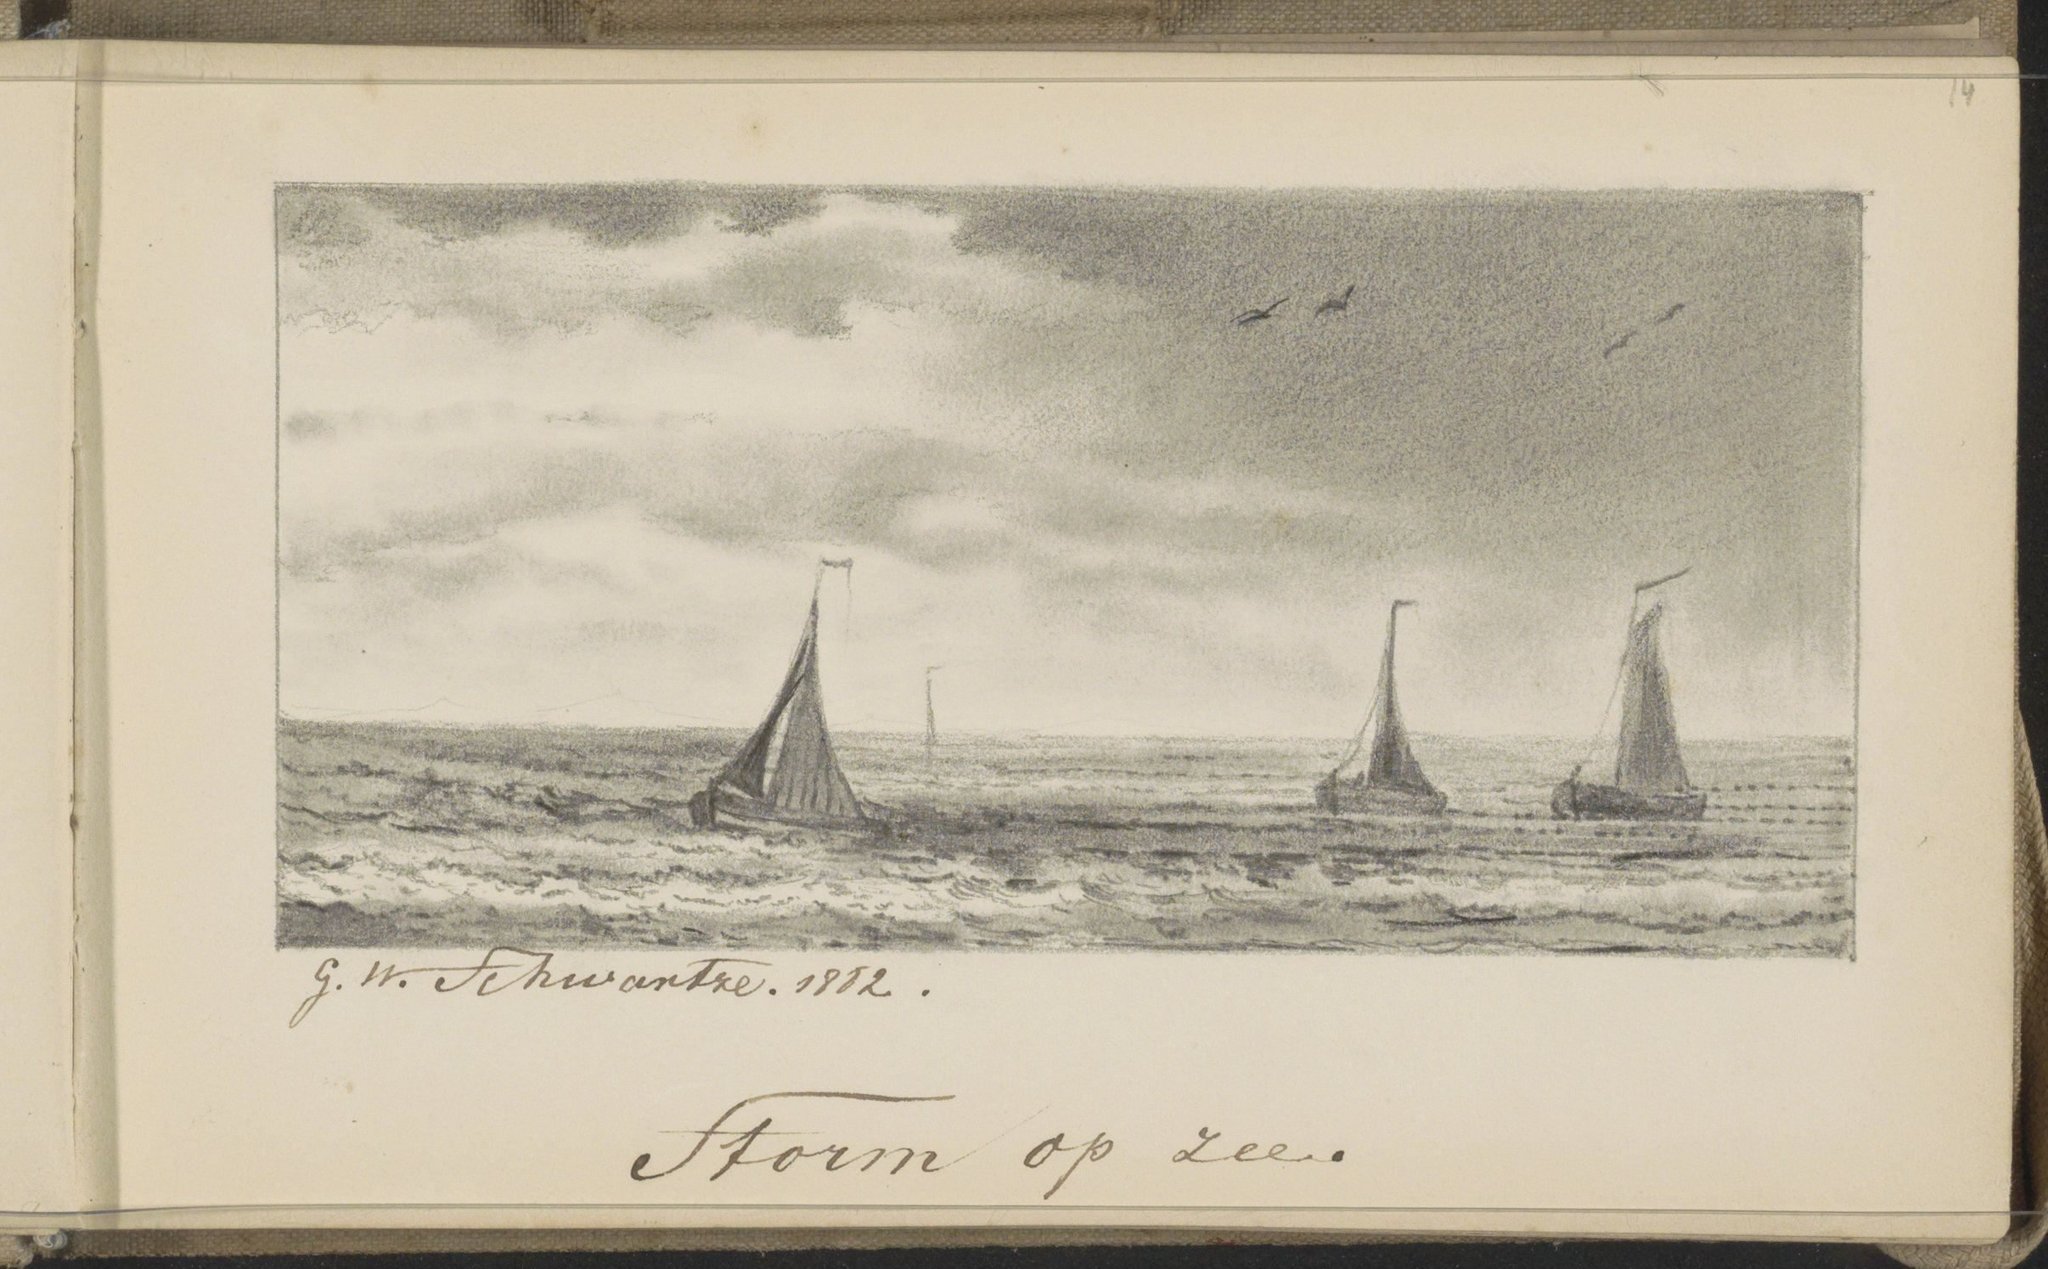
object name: sketchbook leaf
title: Zeilboten op een stormachtige zee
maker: george washington schwartze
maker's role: draughtsman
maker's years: 1857-1909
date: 1882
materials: paper, pencil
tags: sailing-ship, sailing-boat, storm at sea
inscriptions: signature and date: ‘G.W.Schwartze. 1882.’, title: ‘Storm op zee.’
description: Tekening in een kader. Blad 14 recto uit een schetsboek met 54 bladen.